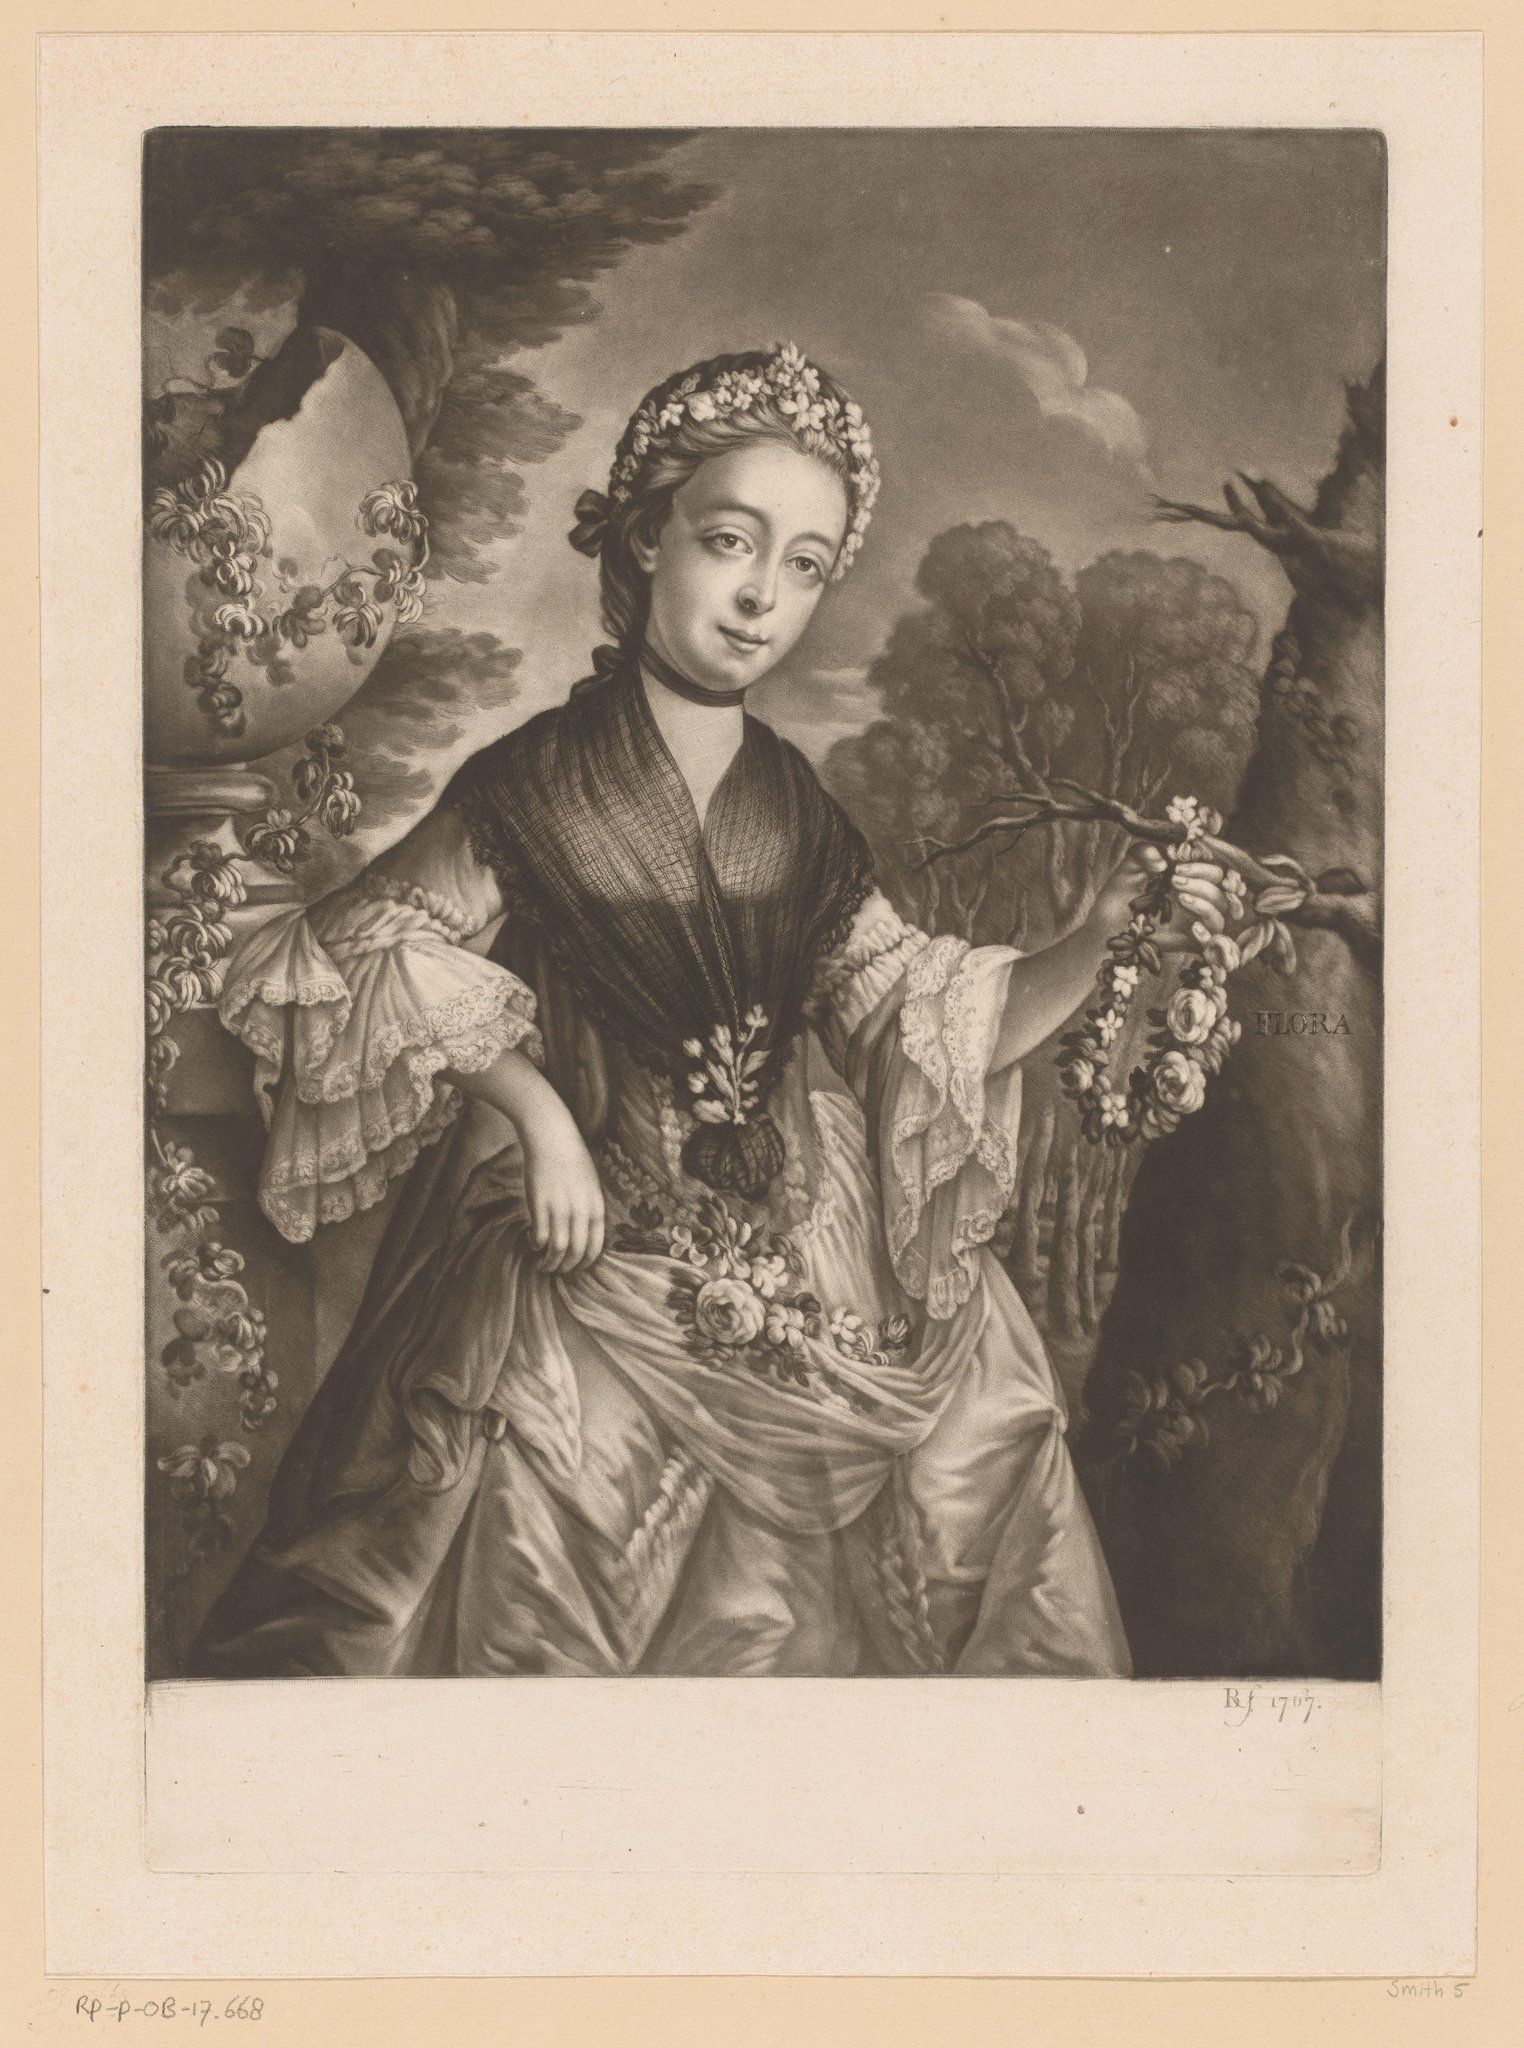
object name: print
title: Portret van Elizabeth Chudleigh als Flora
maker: richard brookshaw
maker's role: print maker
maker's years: 1736-1804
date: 1767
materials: paper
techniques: mezzotint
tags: paris, historical persons - bb - woman, (story of) flora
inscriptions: collector's mark: Lugt 240